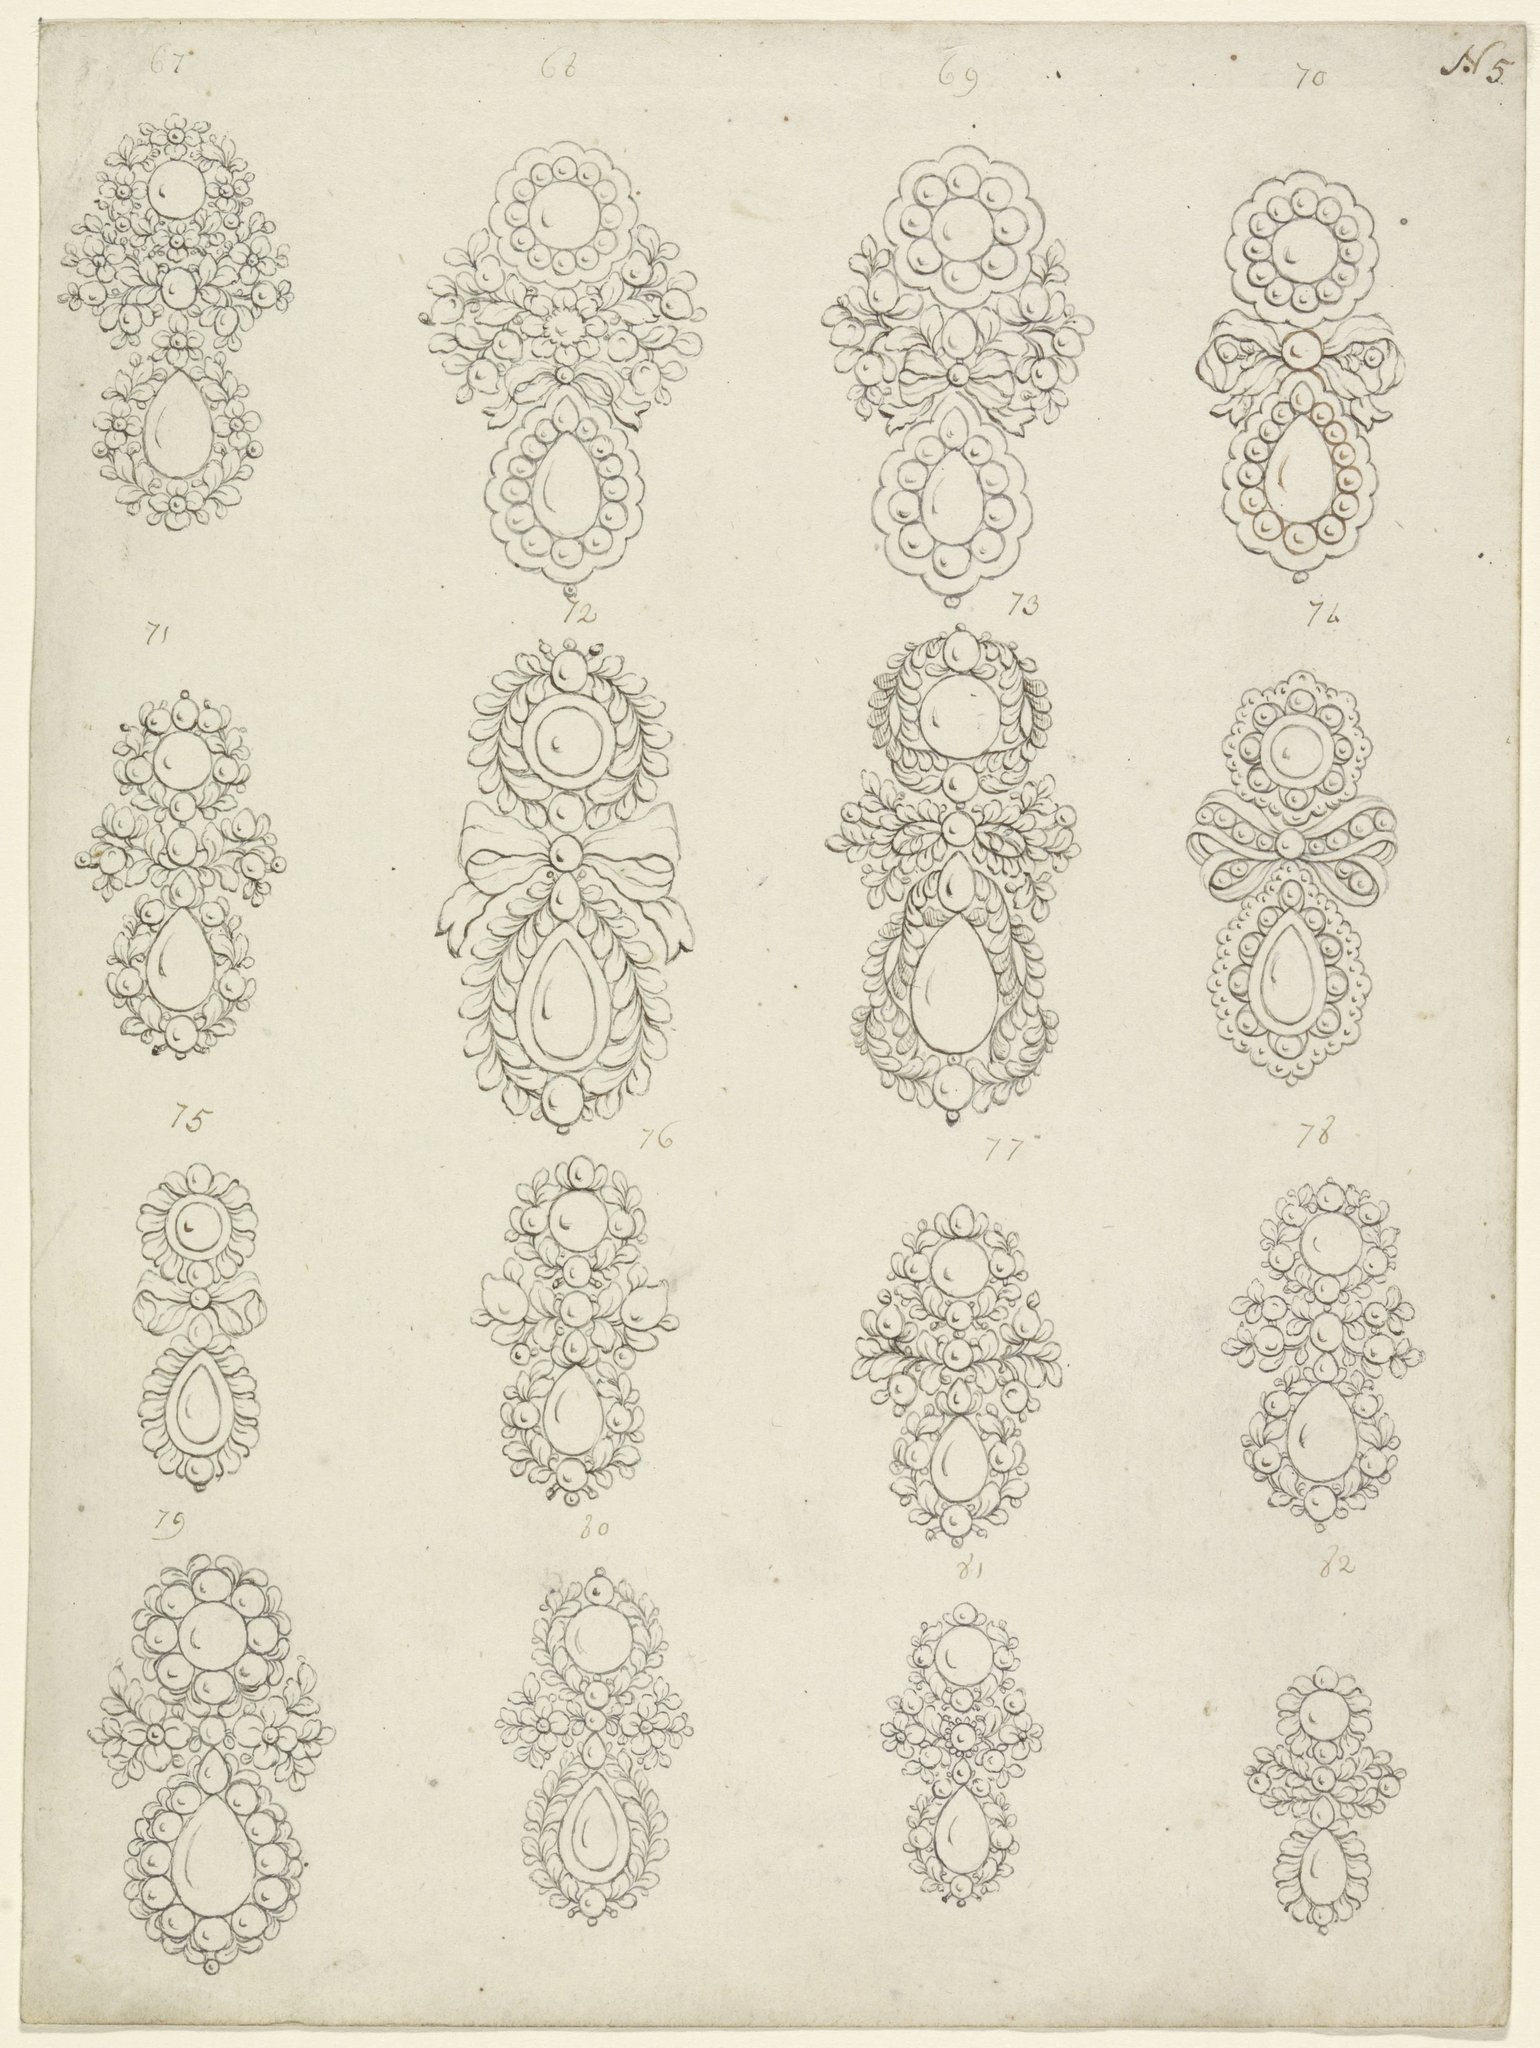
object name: drawing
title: Three Sheets with Designs for Earrings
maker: Anonymous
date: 1750-1780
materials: ink, paper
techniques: pen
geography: france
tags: ear-rings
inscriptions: collector's mark: Lugt 2228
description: These numbered sheets probably come from a presentation catalogue. This was a way for a jeweller or travelling salesman to show his clients many variations on the same type of earrings, always modifying a basic design. The pear-shaped stones that recur in many of the designs point to the use of teardrop-shaped pearls.